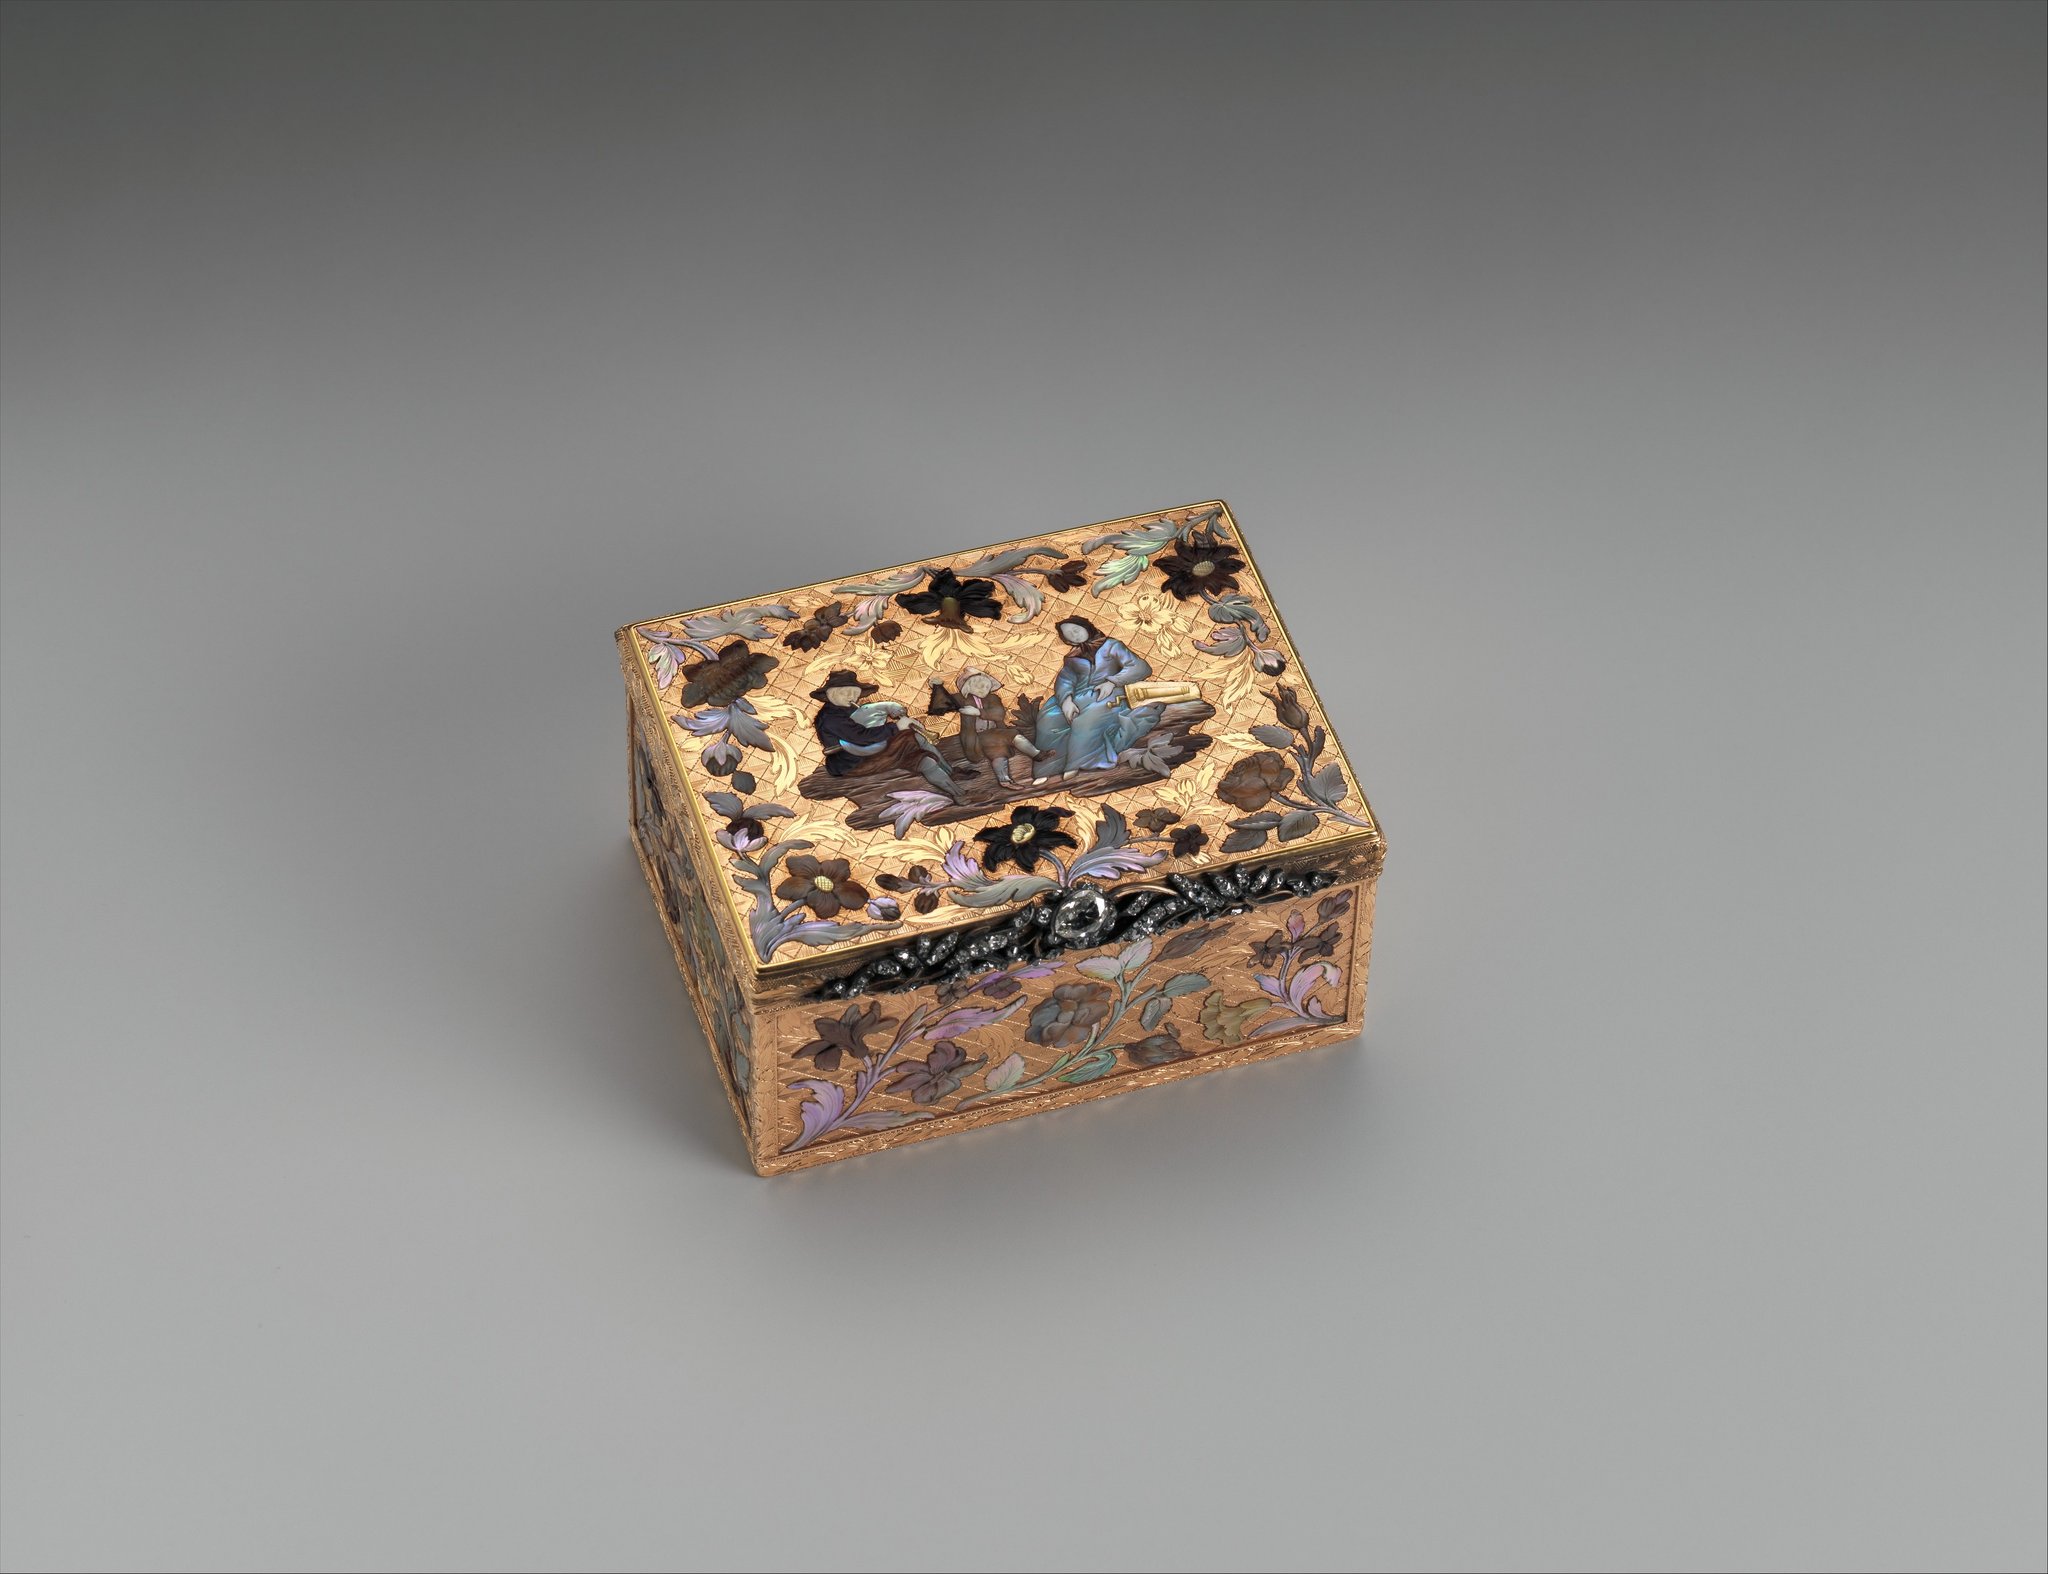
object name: snuffbox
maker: daniel baudesson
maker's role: maker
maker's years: 1716-1785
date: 1755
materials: diamond, gold, ivory, mother of pearl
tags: boys,men,women,musicians